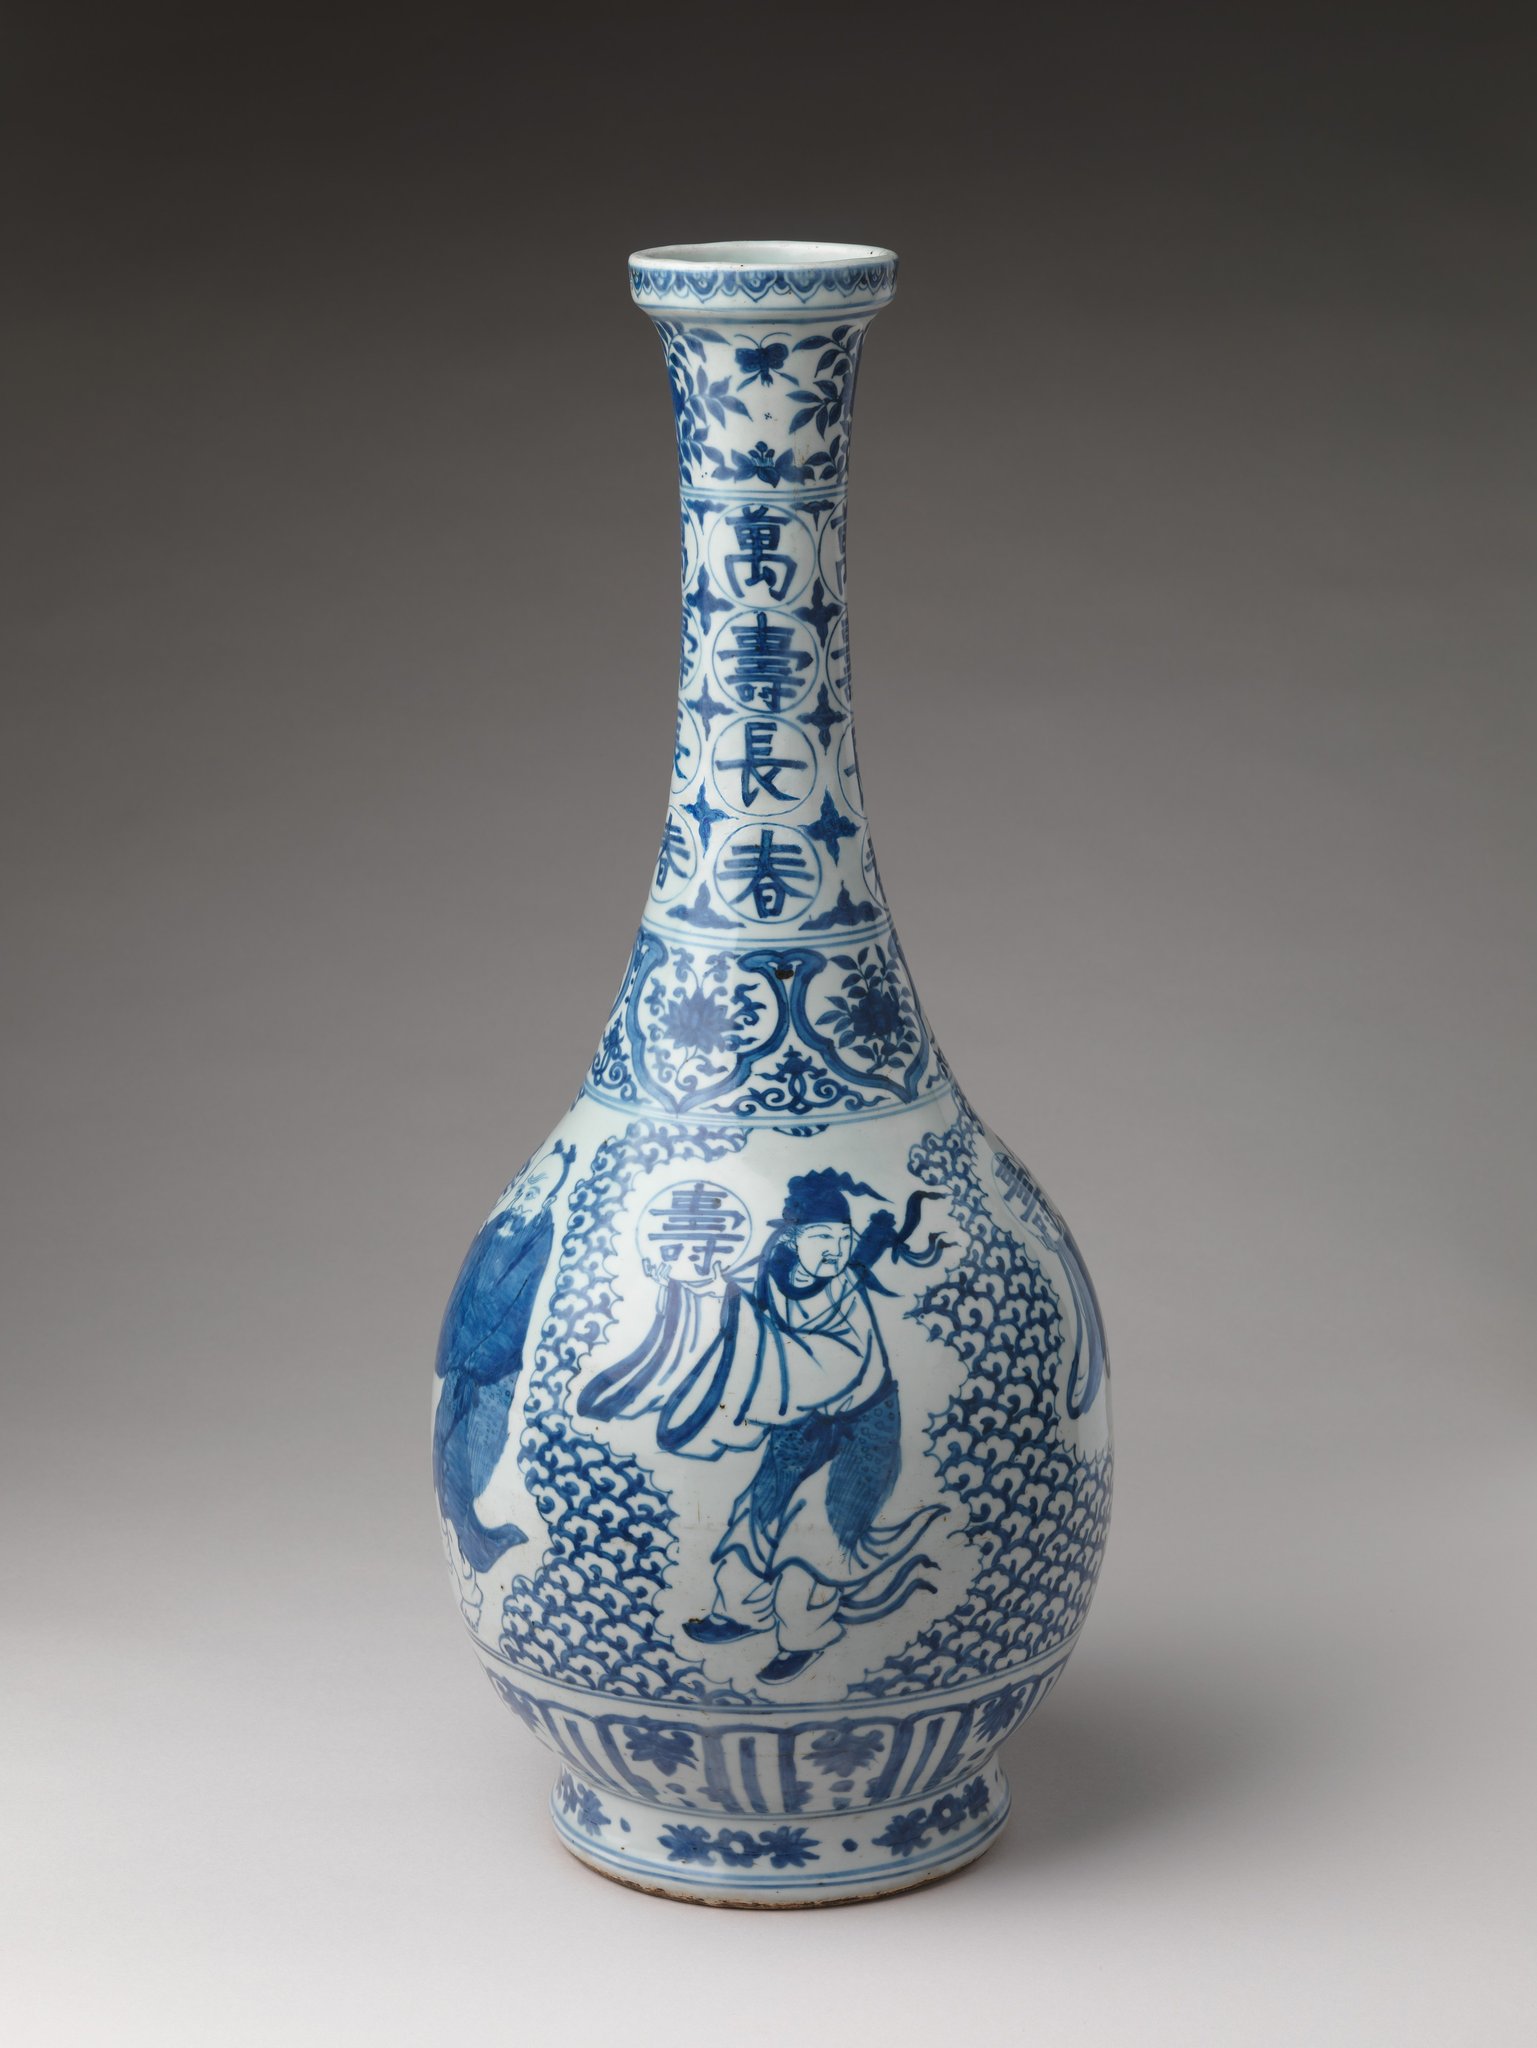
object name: vase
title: Bottle with Daoist Immortals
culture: chinese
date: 1567-1700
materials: cobalt, glaze, porcelain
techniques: painting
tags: men